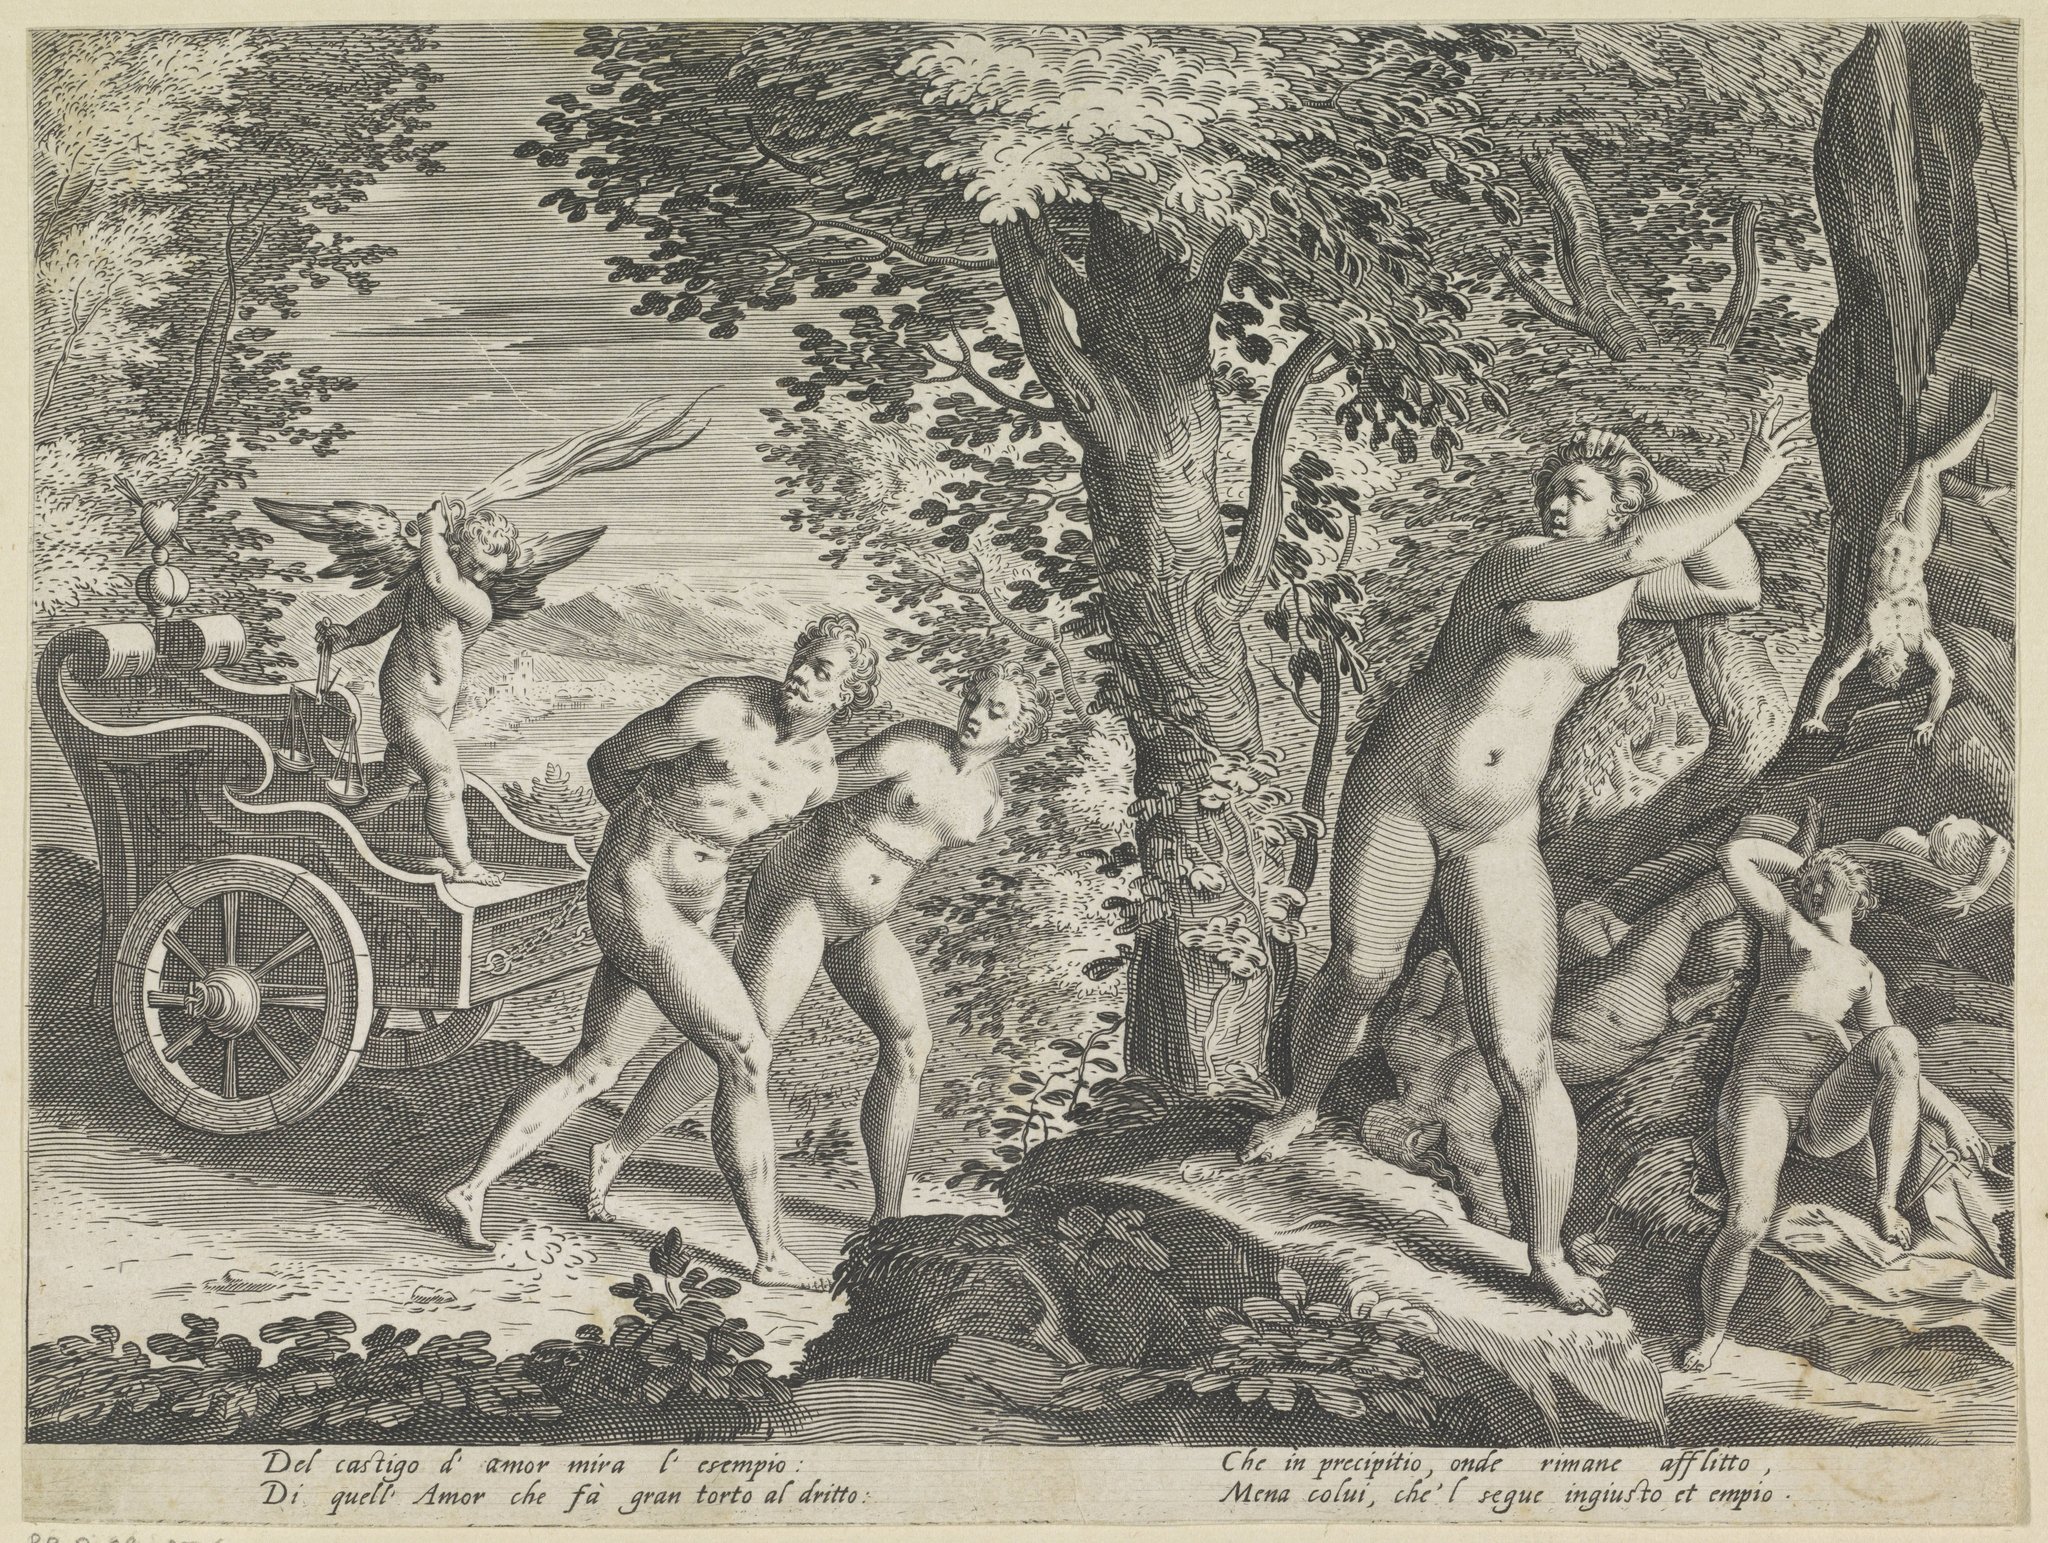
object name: print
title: Verschillende aspecten van de liefde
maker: paolo fiammingo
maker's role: draughtsman, painter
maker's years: 1540-1596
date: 1589-1595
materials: paper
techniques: engraving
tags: chariot, triumphal car, (story of) cupid, amor (eros), seeking death, suicide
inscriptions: collector's mark: Lugt 240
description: Een naakte man en vrouw (mogelijk Adam en Eva) zitten vastgeketend aan een kar met daarop Amor met een vlammend zwaard. Rechts een ongeruste figuur bij een groepje lichamen van mensen die zelfmoord hebben gepleegd. Naast een van de lichamen ligt een dolk en een ander lichaam valt langs een rotswand naar beneden. Italiaans vers in ondermarge.